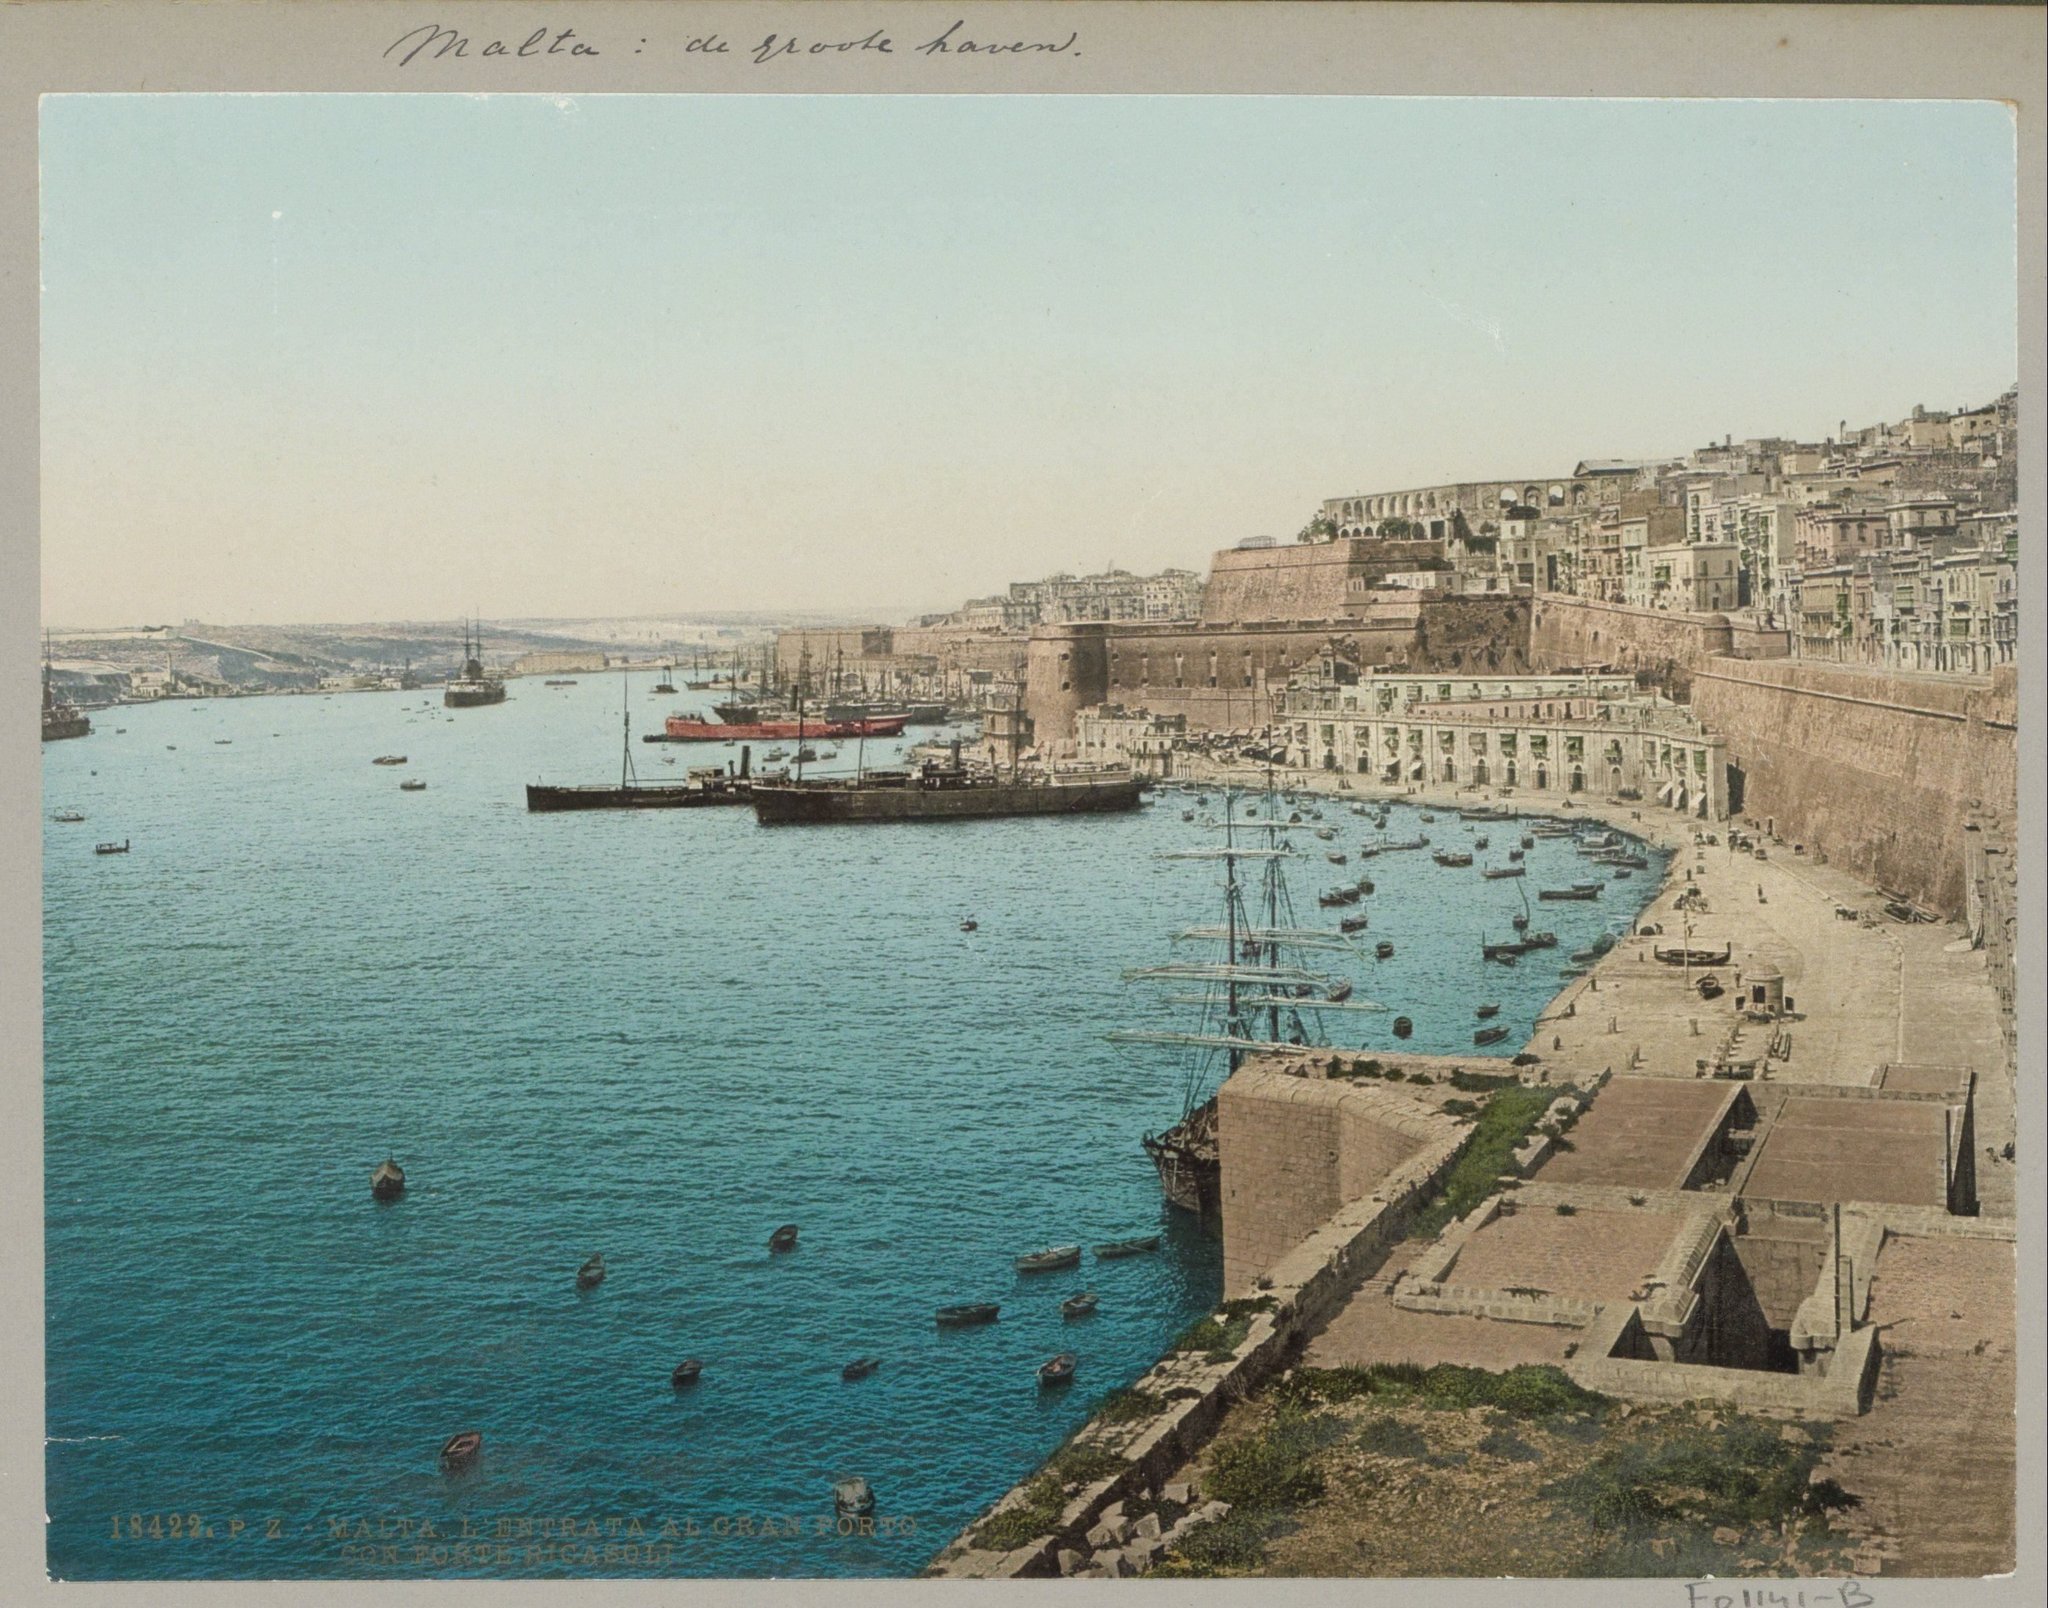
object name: photomechanical print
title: Malta. L'Entrata al gran porto con forte Ricasoli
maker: Anonymous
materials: paper, photographic process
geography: zurich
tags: fortress, harbour (+ view ~ vehicle, ship, etc.)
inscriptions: number: ‘18422’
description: Onderdeel van Fotoalbum van een reis door Zuid-Europa en het Midden-Oosten.